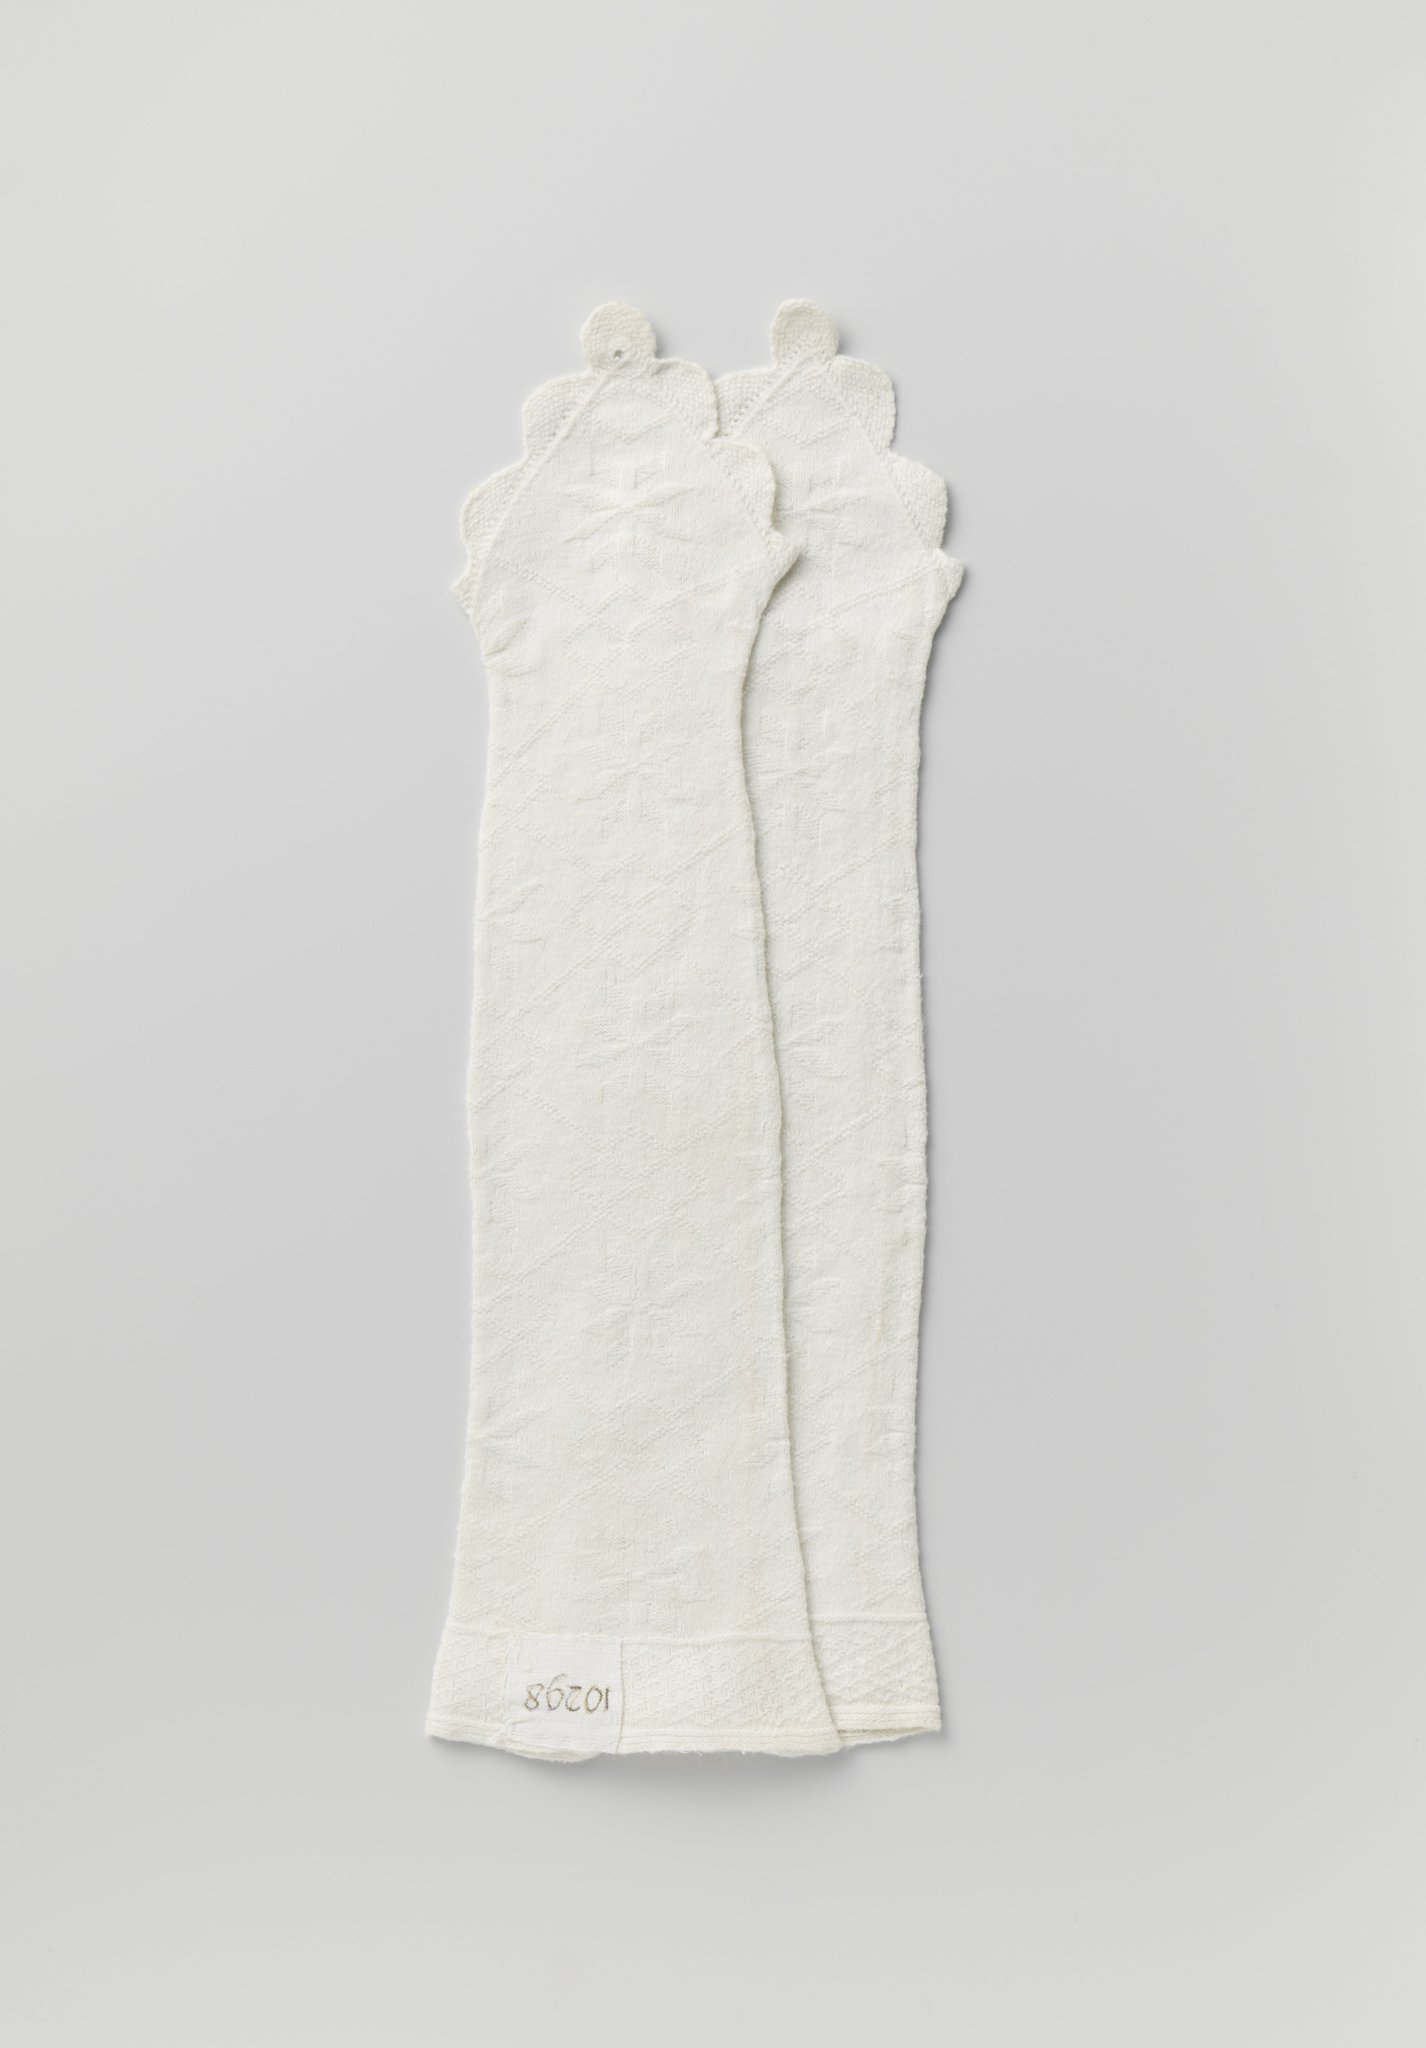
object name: mitt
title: Mitaine van witte gebreide katoen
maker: Anonymous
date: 1750-1800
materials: cotton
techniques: knitting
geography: zaanstreek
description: Mitaine van witte gebreide katoen, driehoekige handrug met ronde gehaakte schulpen. Ingebreid patroon van rasterwerk met ruit en bloemen.